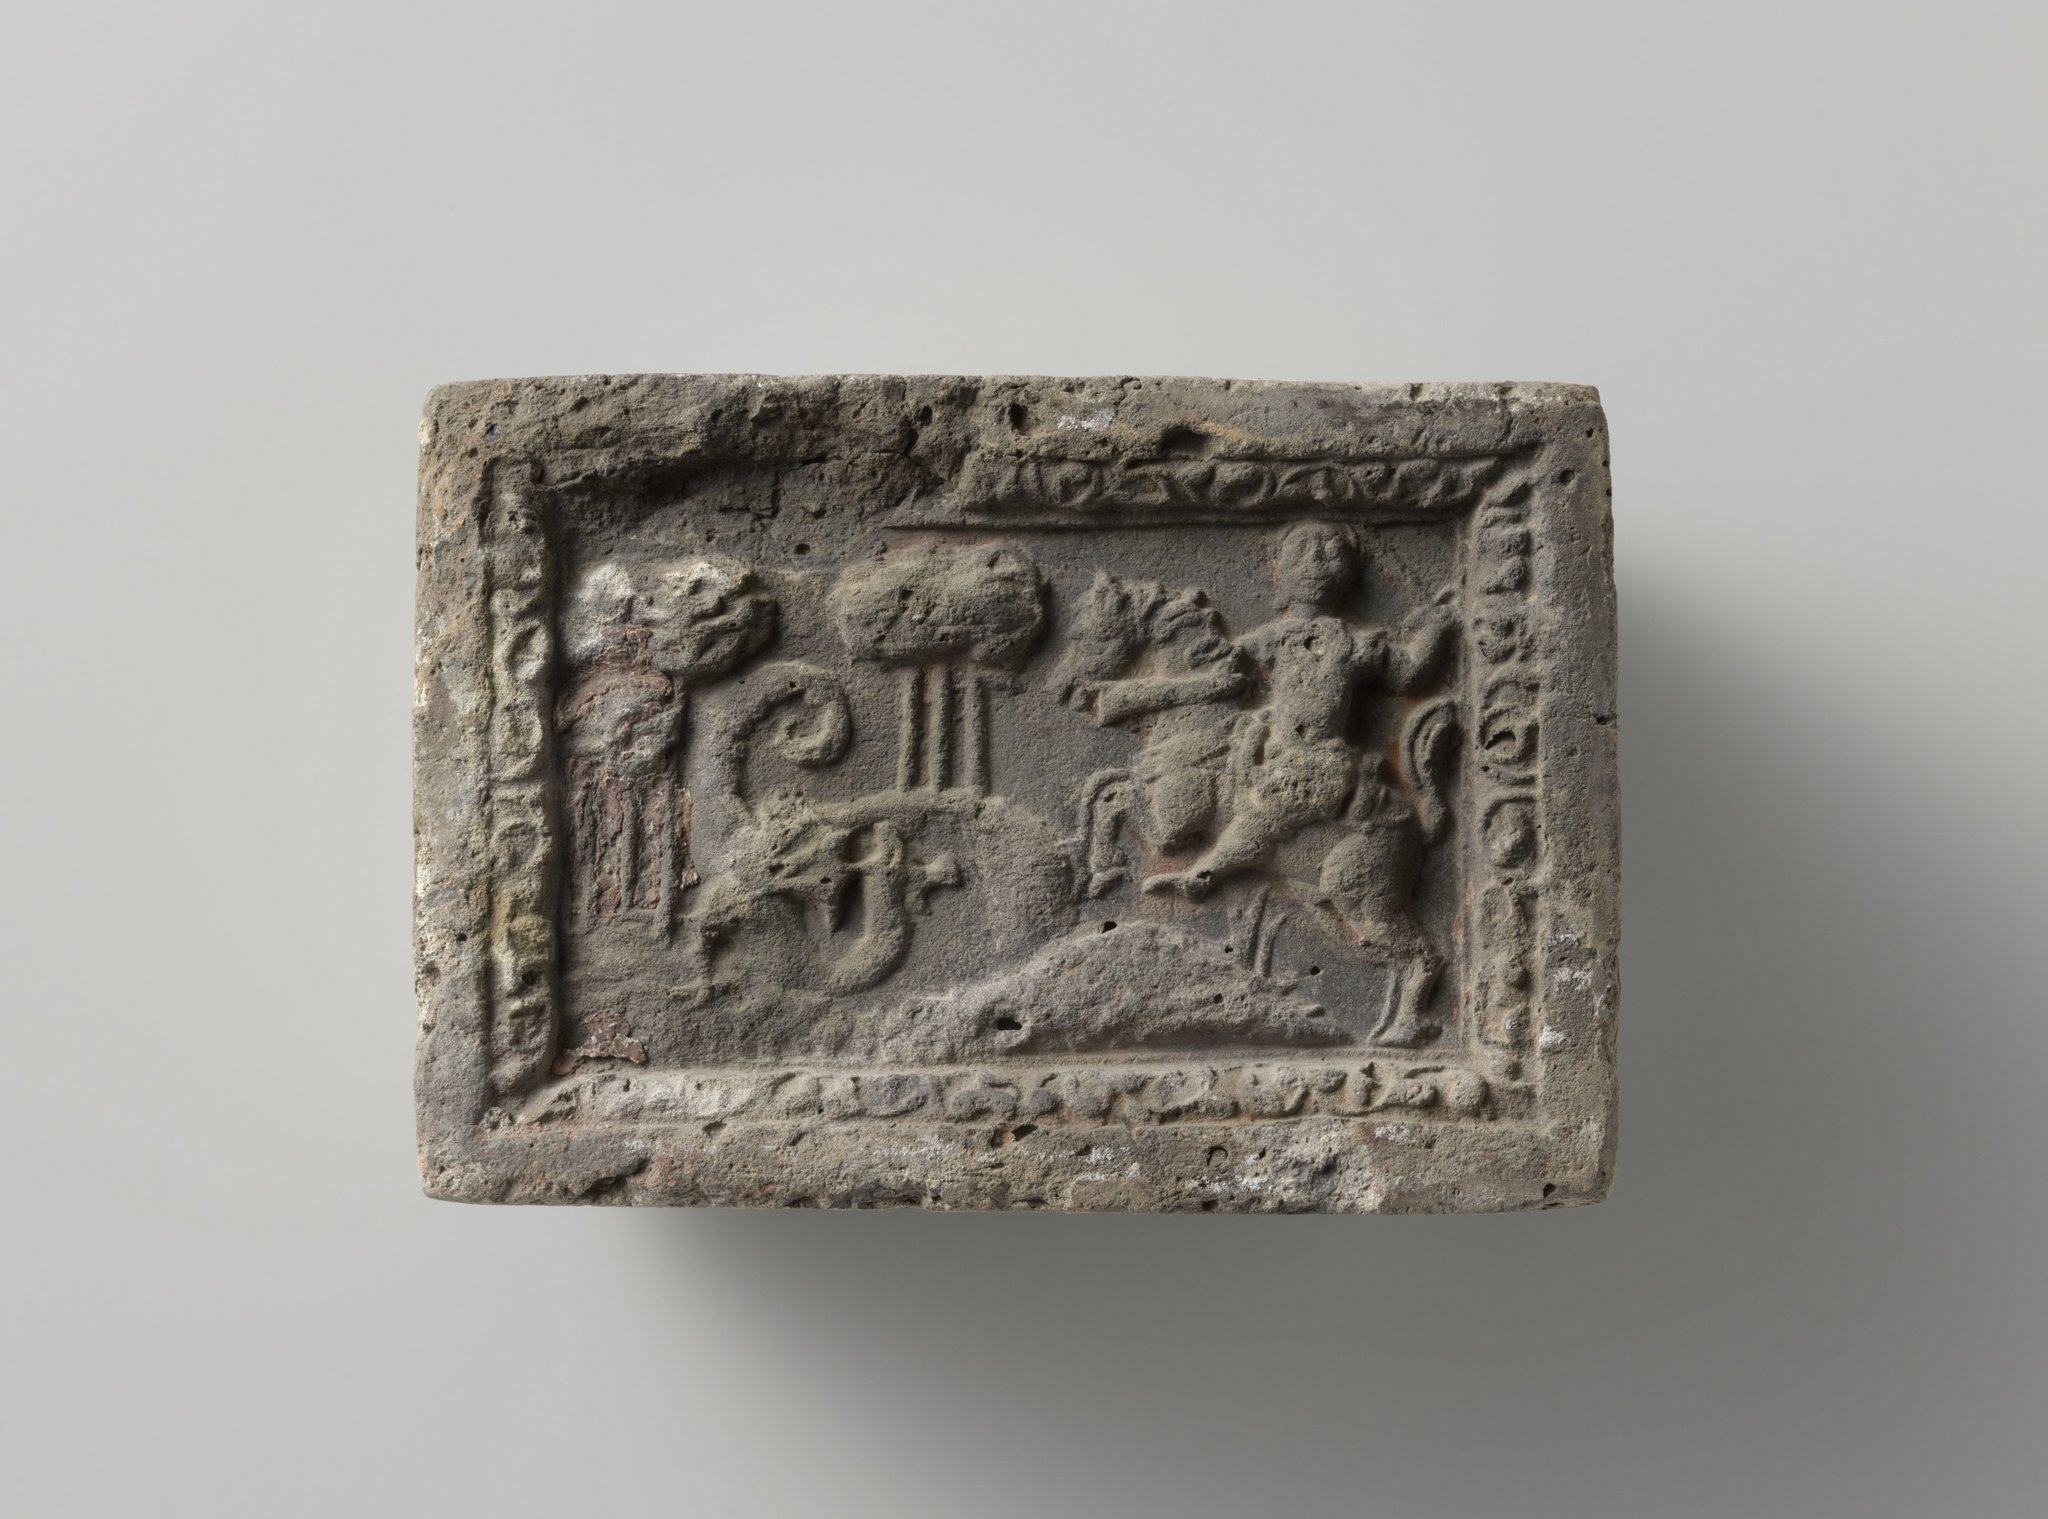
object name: architectural element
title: Haardsteen, waarop een gevecht van een ruiter met een draak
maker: Anonymous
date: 1400-1950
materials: earthenware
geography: southern netherlands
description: Haardsteen, waarop een gevecht van een ruiter met een draak in een landschap. In vierkante sierlijst. Van fijne gebakken aarde.